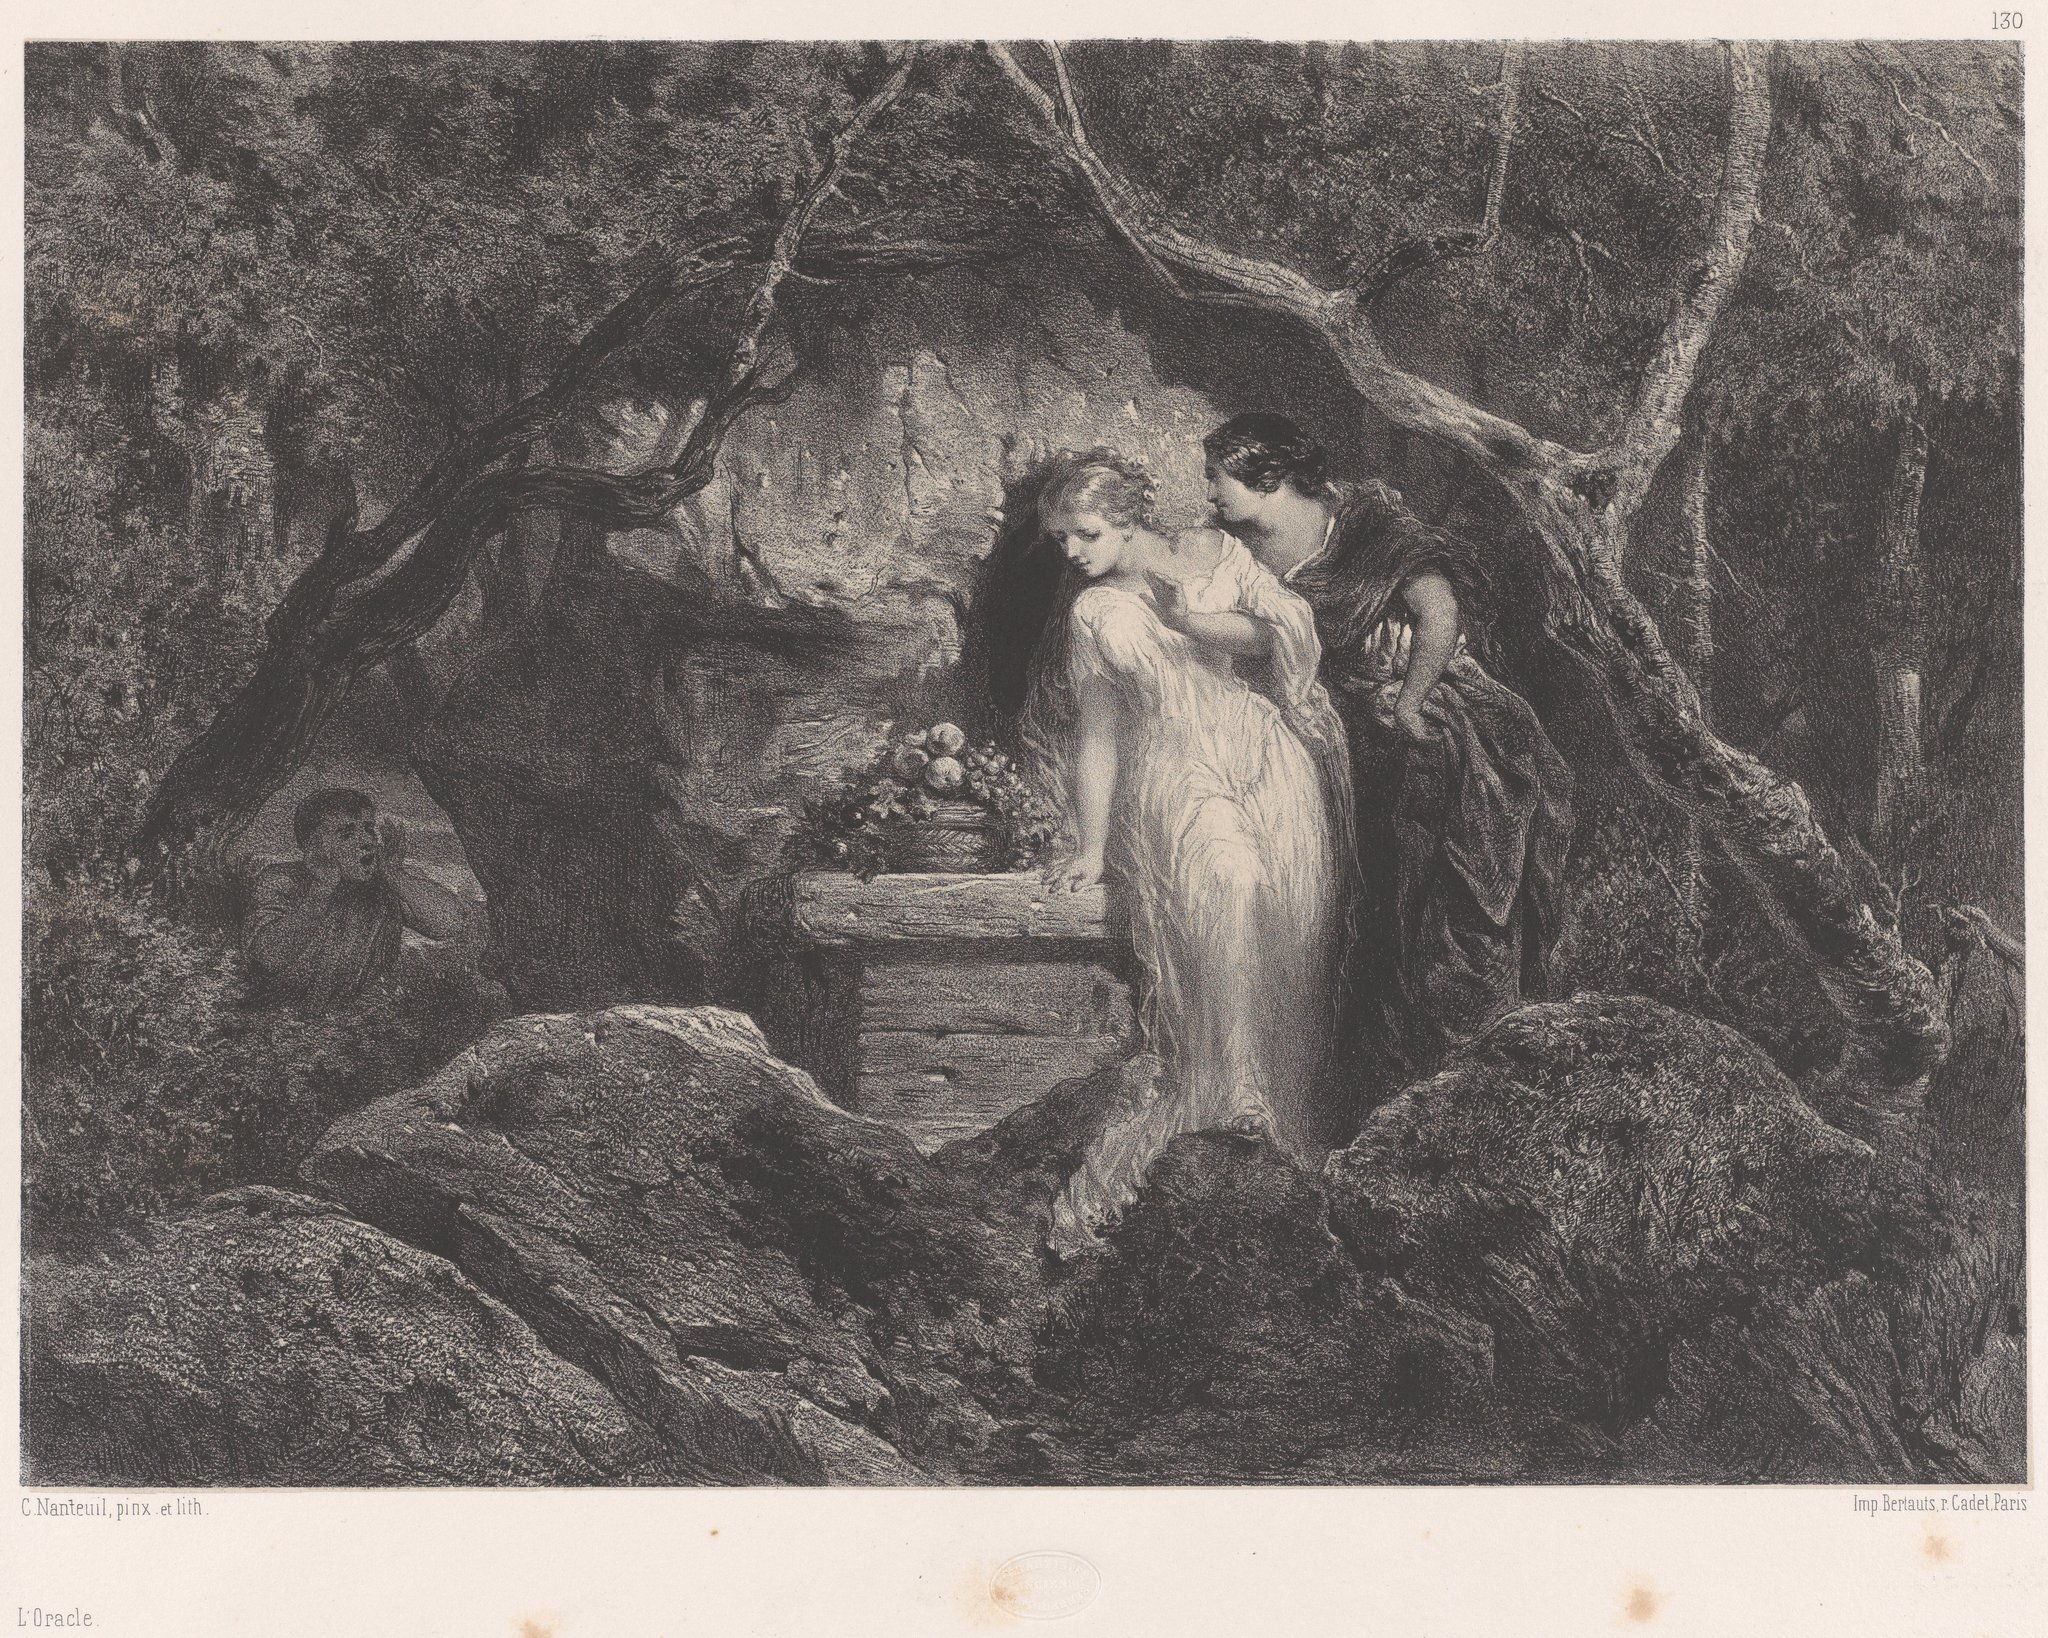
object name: print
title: The Oracle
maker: célestin nanteuil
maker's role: artist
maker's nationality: french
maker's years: 1813-1873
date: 1837-1870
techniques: lithograph